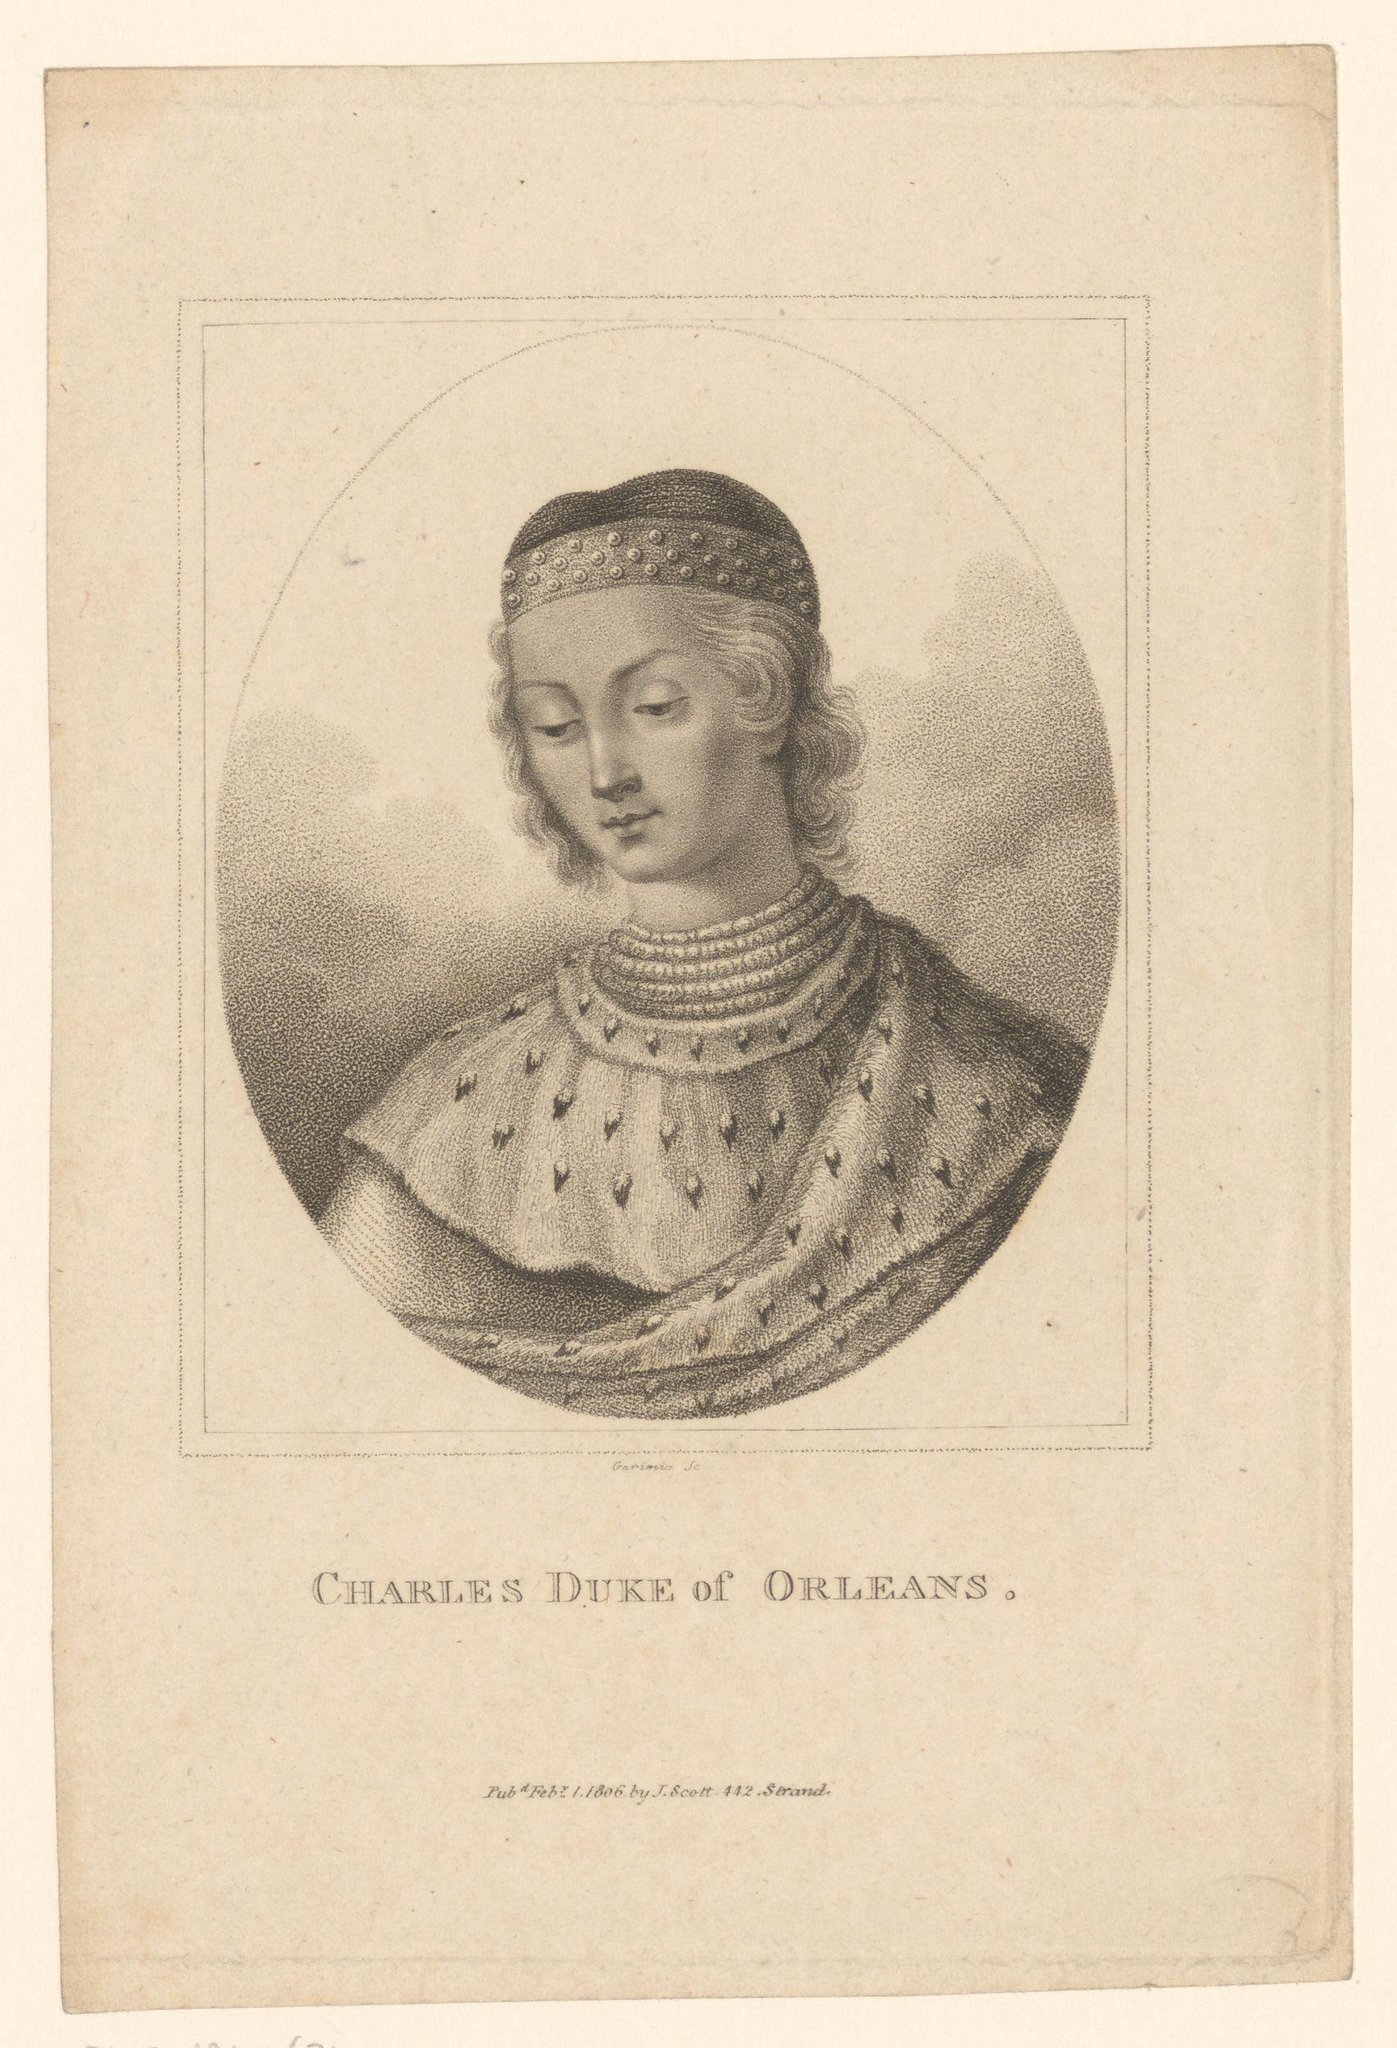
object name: print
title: Portret van Karel van Orléans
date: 1802-1805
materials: paper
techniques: stippling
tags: paris, historical persons, portrait of a writer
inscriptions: collector's mark: Lugt 2228